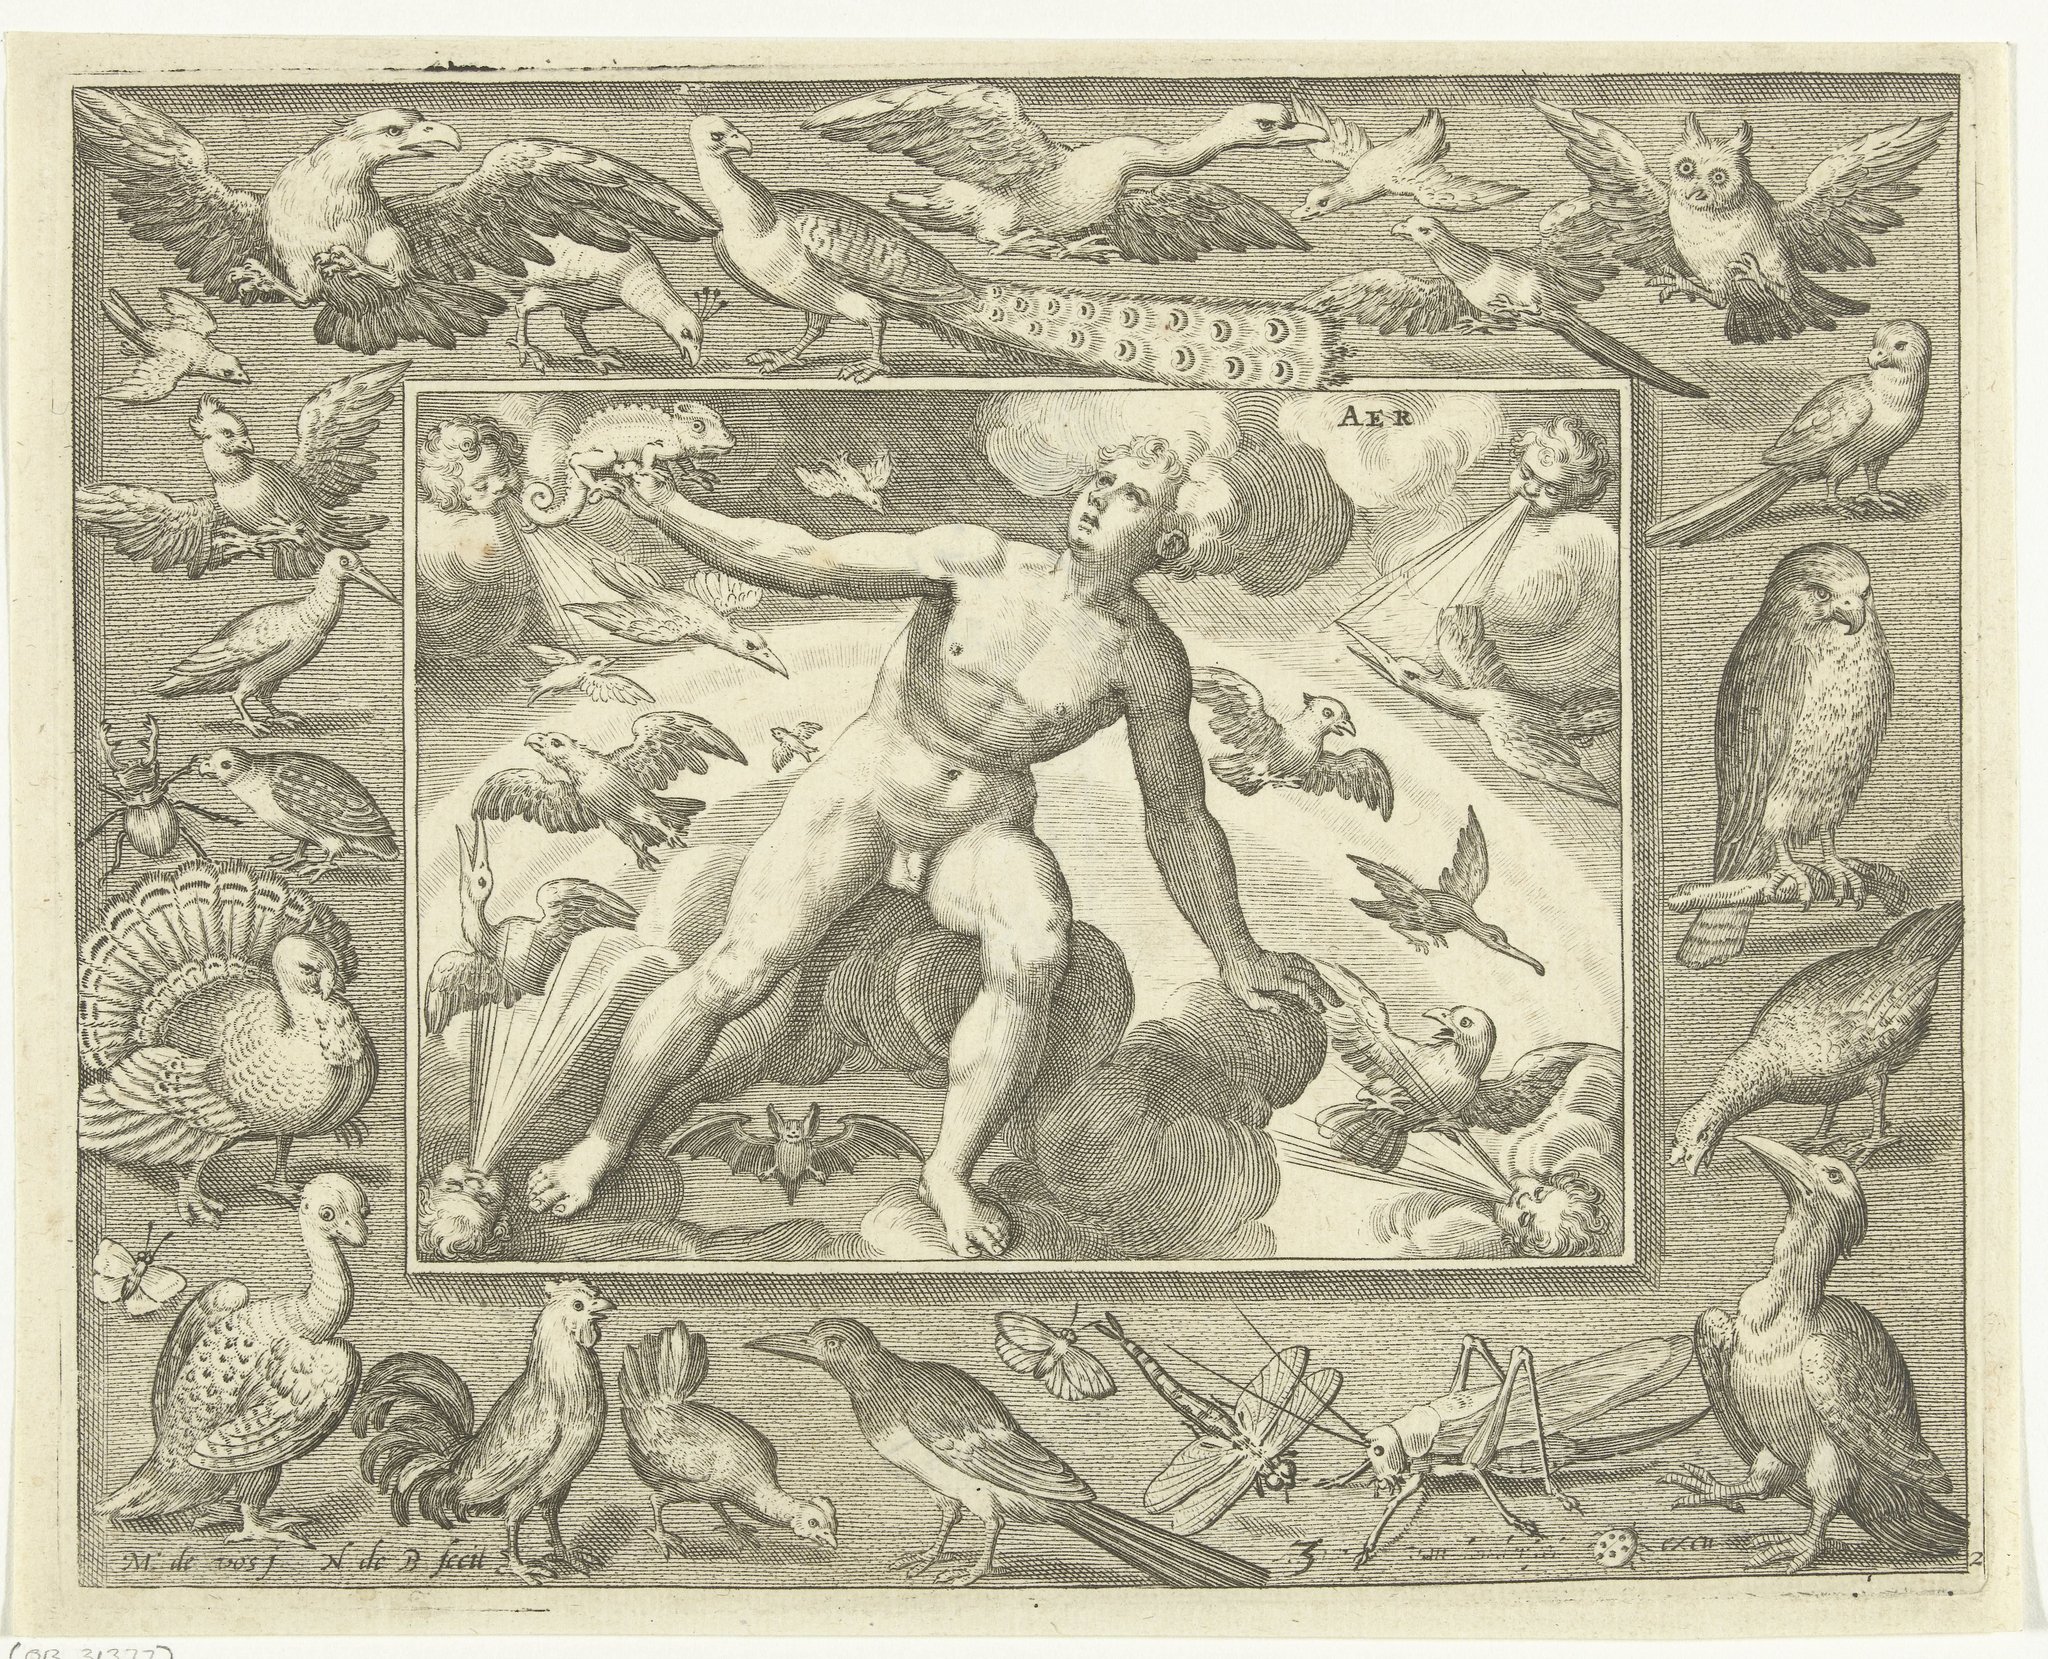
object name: print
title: Element lucht als jonge man op wolken tussen vliegende vogels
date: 1581-1656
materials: paper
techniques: engraving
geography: netherlands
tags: air (one of the four elements)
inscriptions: collector's mark: Lugt 2228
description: Element lucht als jonge man zittend op wolken met kameleon op zijn hand tussen vliegende vogels en vleermuis. Van vier windrichtingen blaast de wind. In omlijsting met vogels als uil, pauw en kalkoen en insecten als sprinkhaan en libelle.